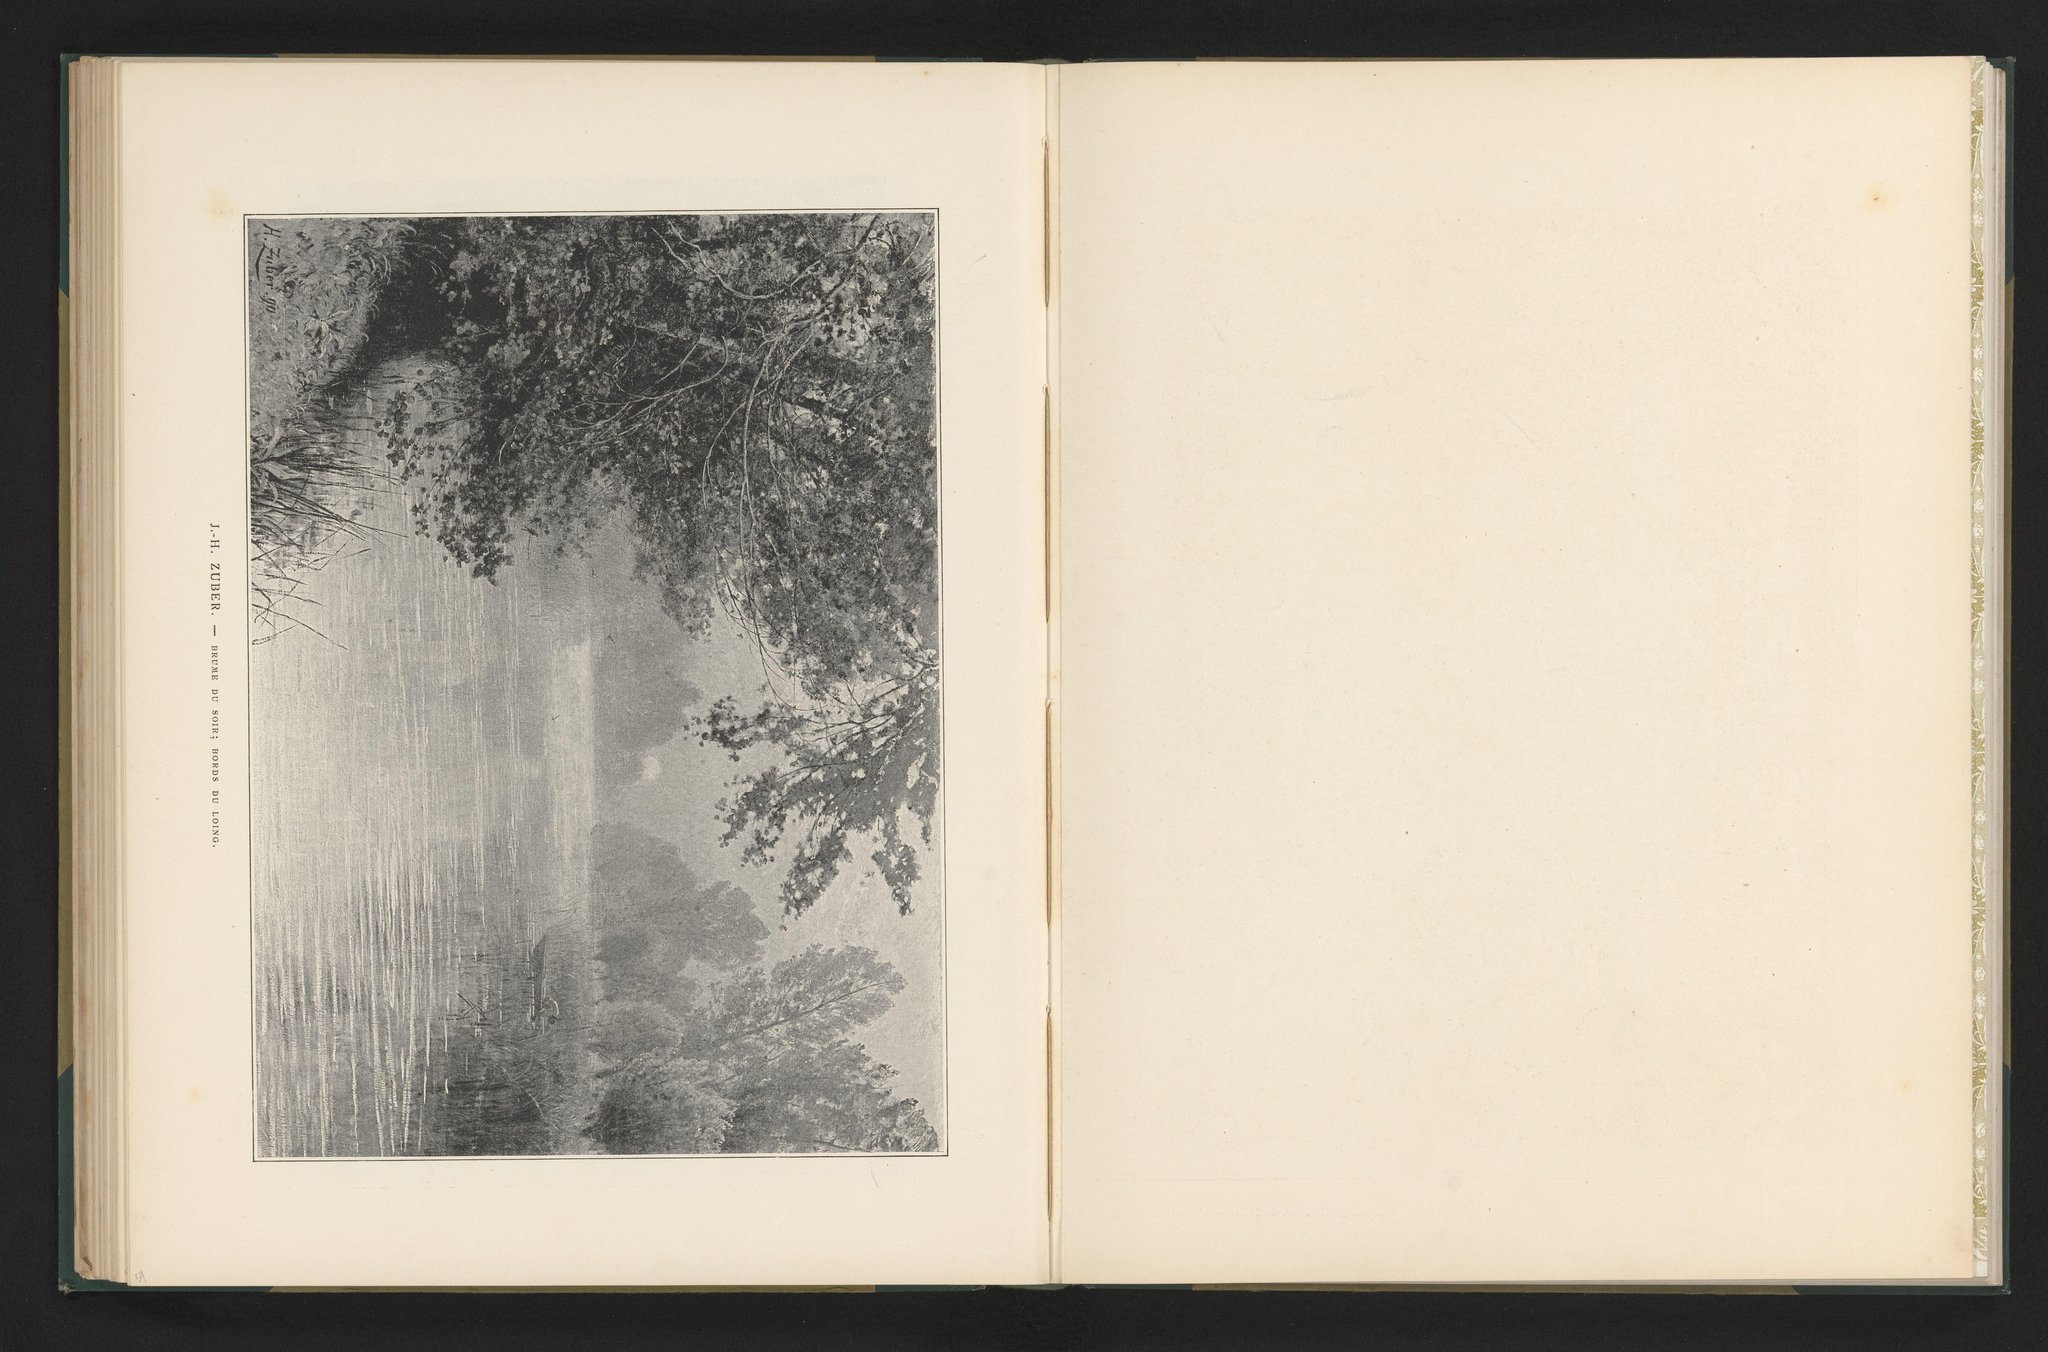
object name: reproduction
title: Reproductie van een schilderij van een gezicht op de Loing in de mist door Henri Zuber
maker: Anonymous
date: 1885-1901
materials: paper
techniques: autotype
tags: river, mist, fog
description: Prent op pagina 28 van Figaro-Salon (par Albert Wolff).